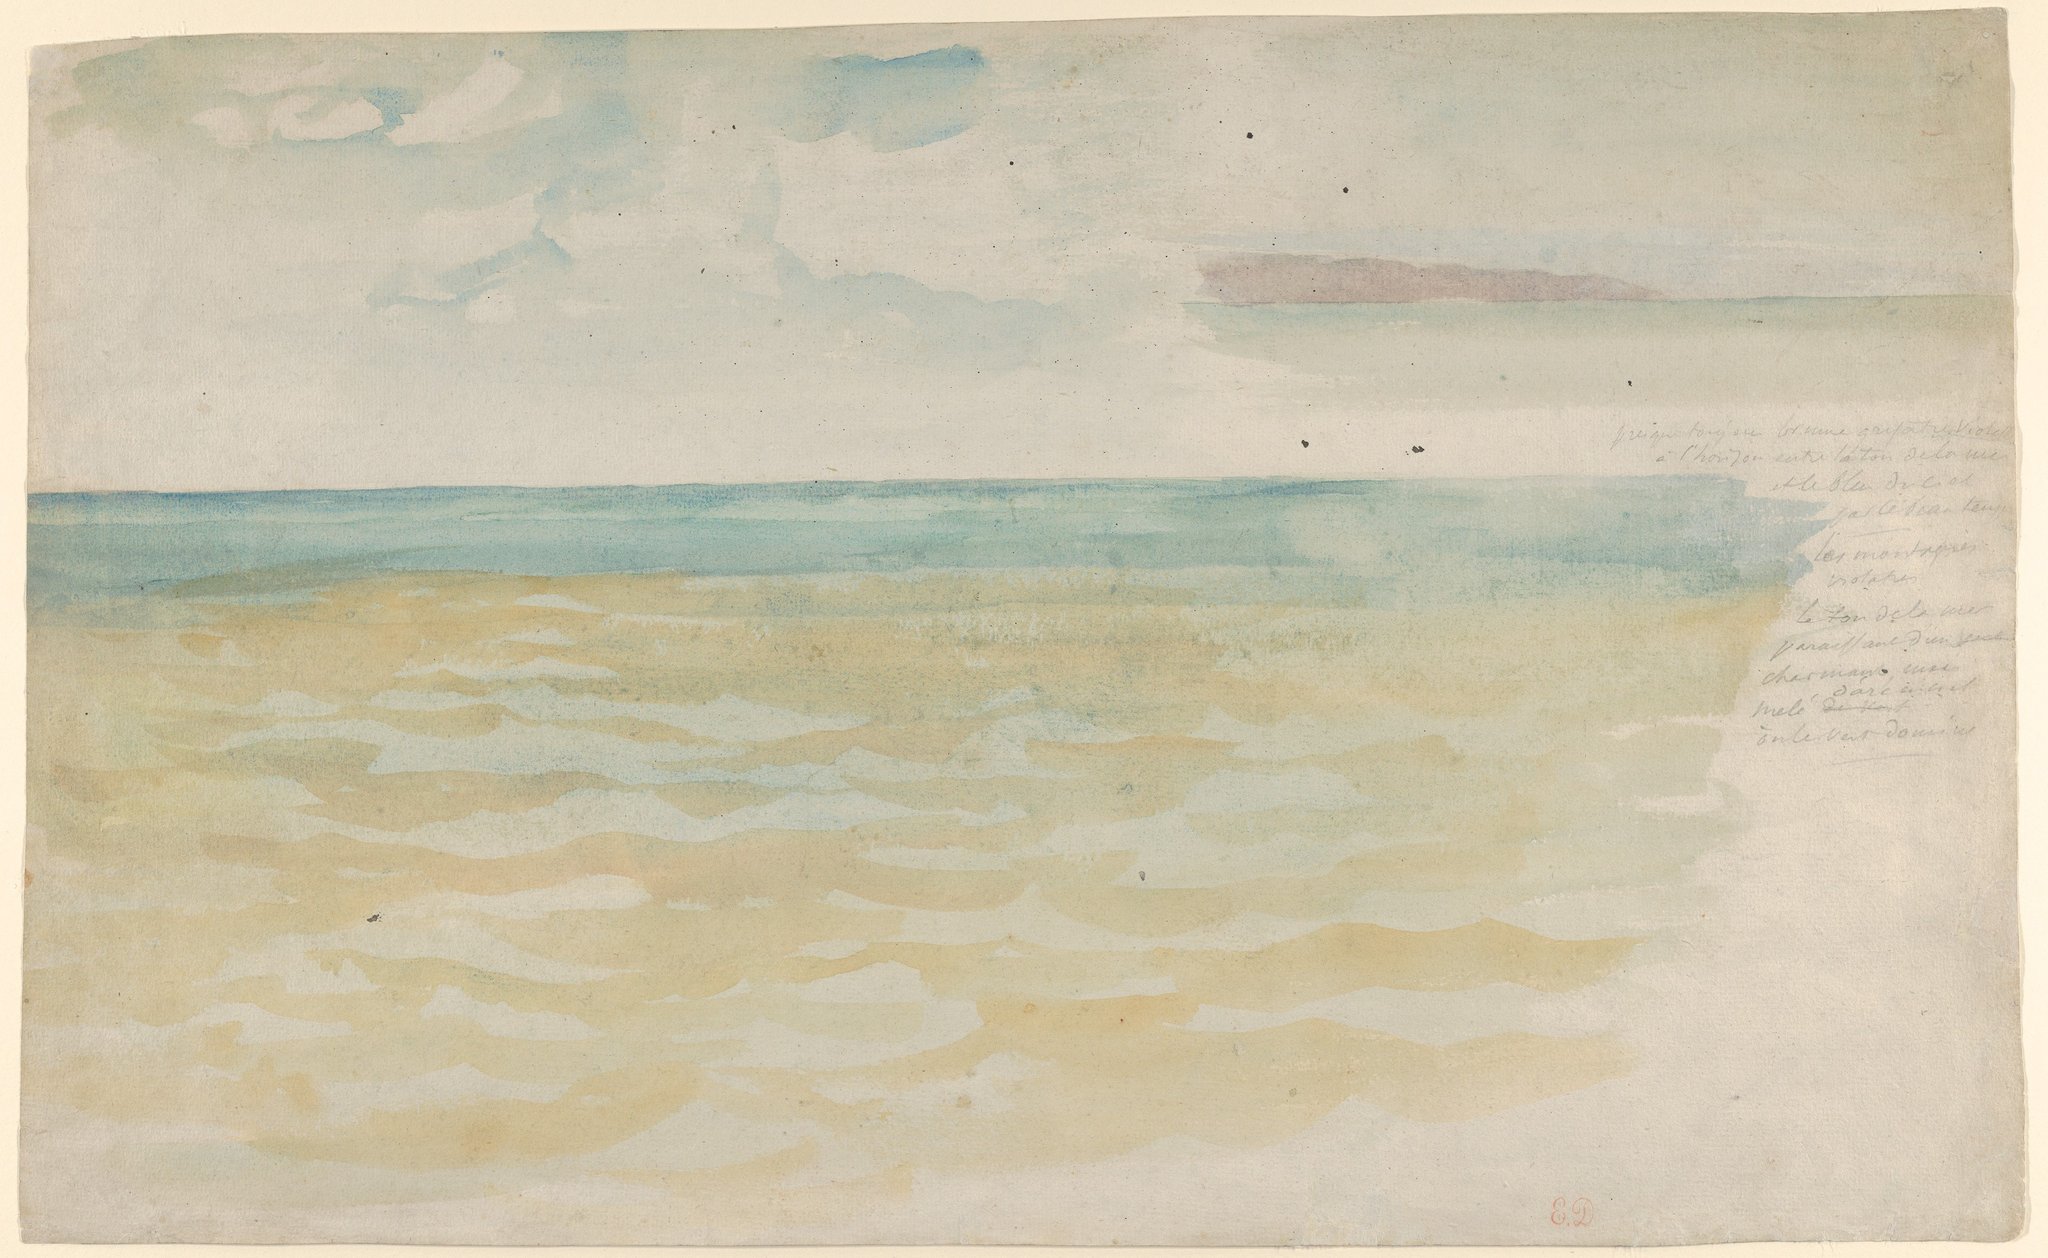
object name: drawing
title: The Sea at Dieppe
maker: eugène delacroix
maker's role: artist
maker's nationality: french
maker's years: 1798-1863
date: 1852-1854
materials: paper, watercolor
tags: seascapes